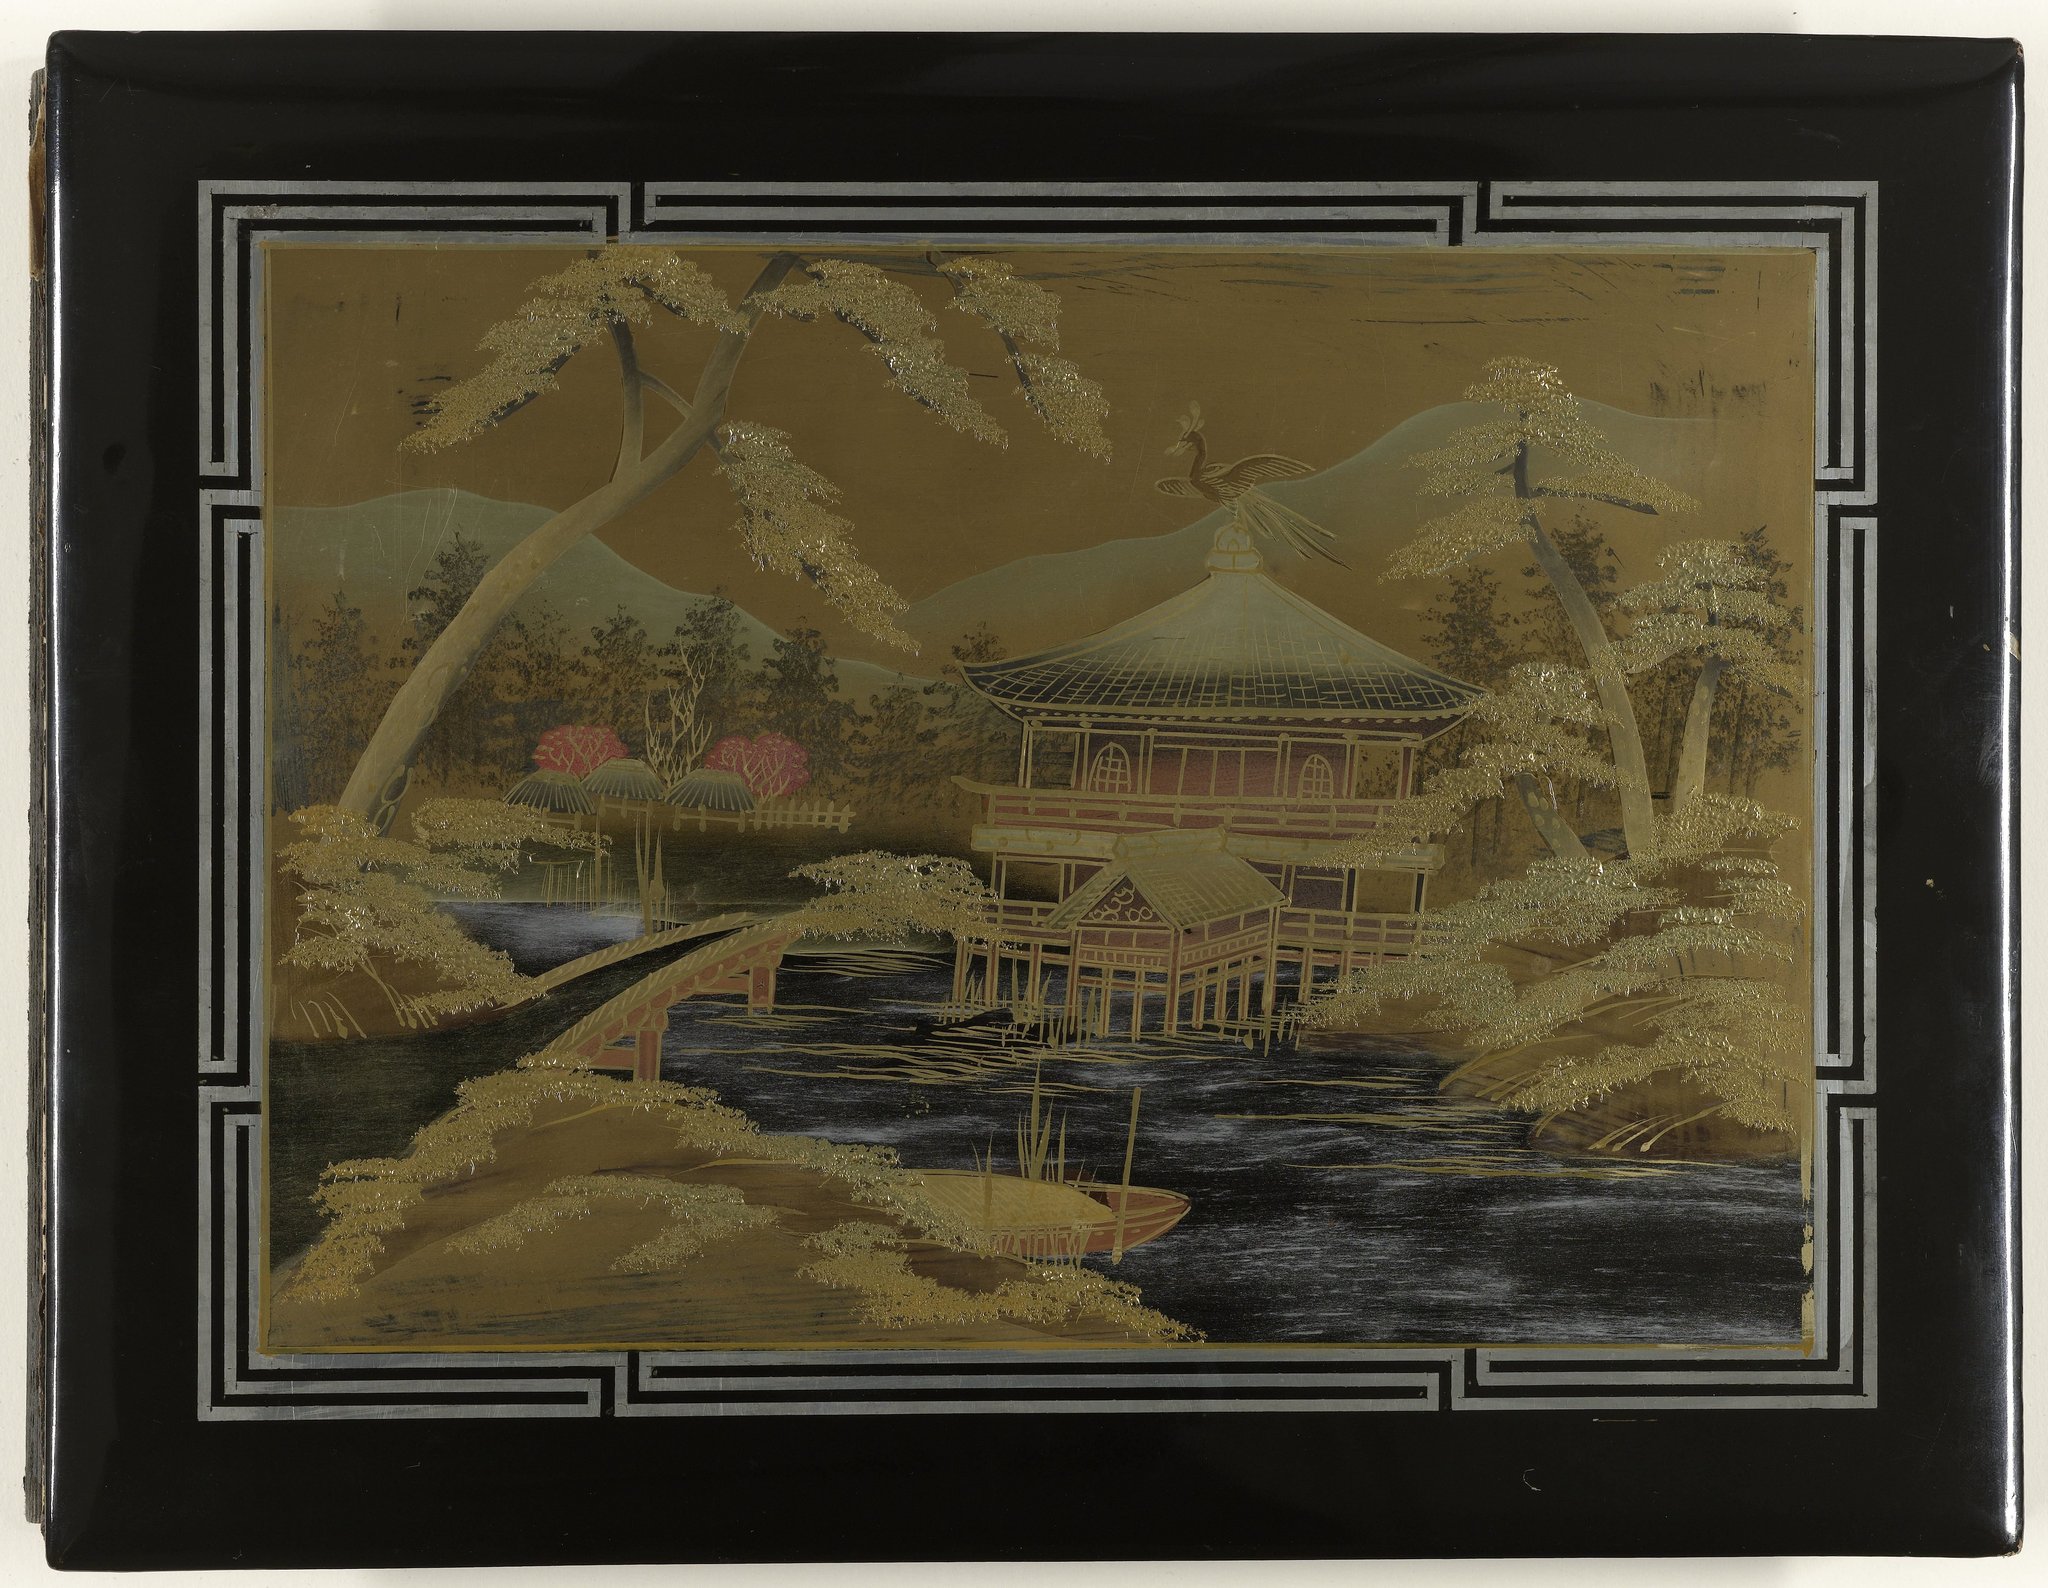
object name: slip in album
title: Fotoalbum van Jet Vonk uit Zuid-Celebes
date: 1935-1947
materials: lacquer, paper, photographic support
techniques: gelatin silver print, lacquer, writing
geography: netherlands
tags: r.h. vonk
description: Familiealbum van Jet Vonk, bestaande uit 34 pagina's met foto's en 8 lege pagina's. De voorkant van het album bestaat uit een paneel met een landschap in Chinees lakwerk. Het album bevat onder meer foto's van de installatie van de sultan van Boeton, Vorst van Goa, begin 1938, en loopt door tot de terugkeer van de familie in 1947 naar Nederland. De meeste foto's hebben handgeschreven onderschriften. Jet Vonk kreeg het (toen lege) album van Roel Blok in 1935 ter herinnering aan haar tijd in "Pagar Alan". Jet Vonk was de dochter van R.H. Vonk, assistent-resident van Boeton, gestationeerd op Zuid-Celebes. Een aantal losse foto's is aan het album toegevoegd.